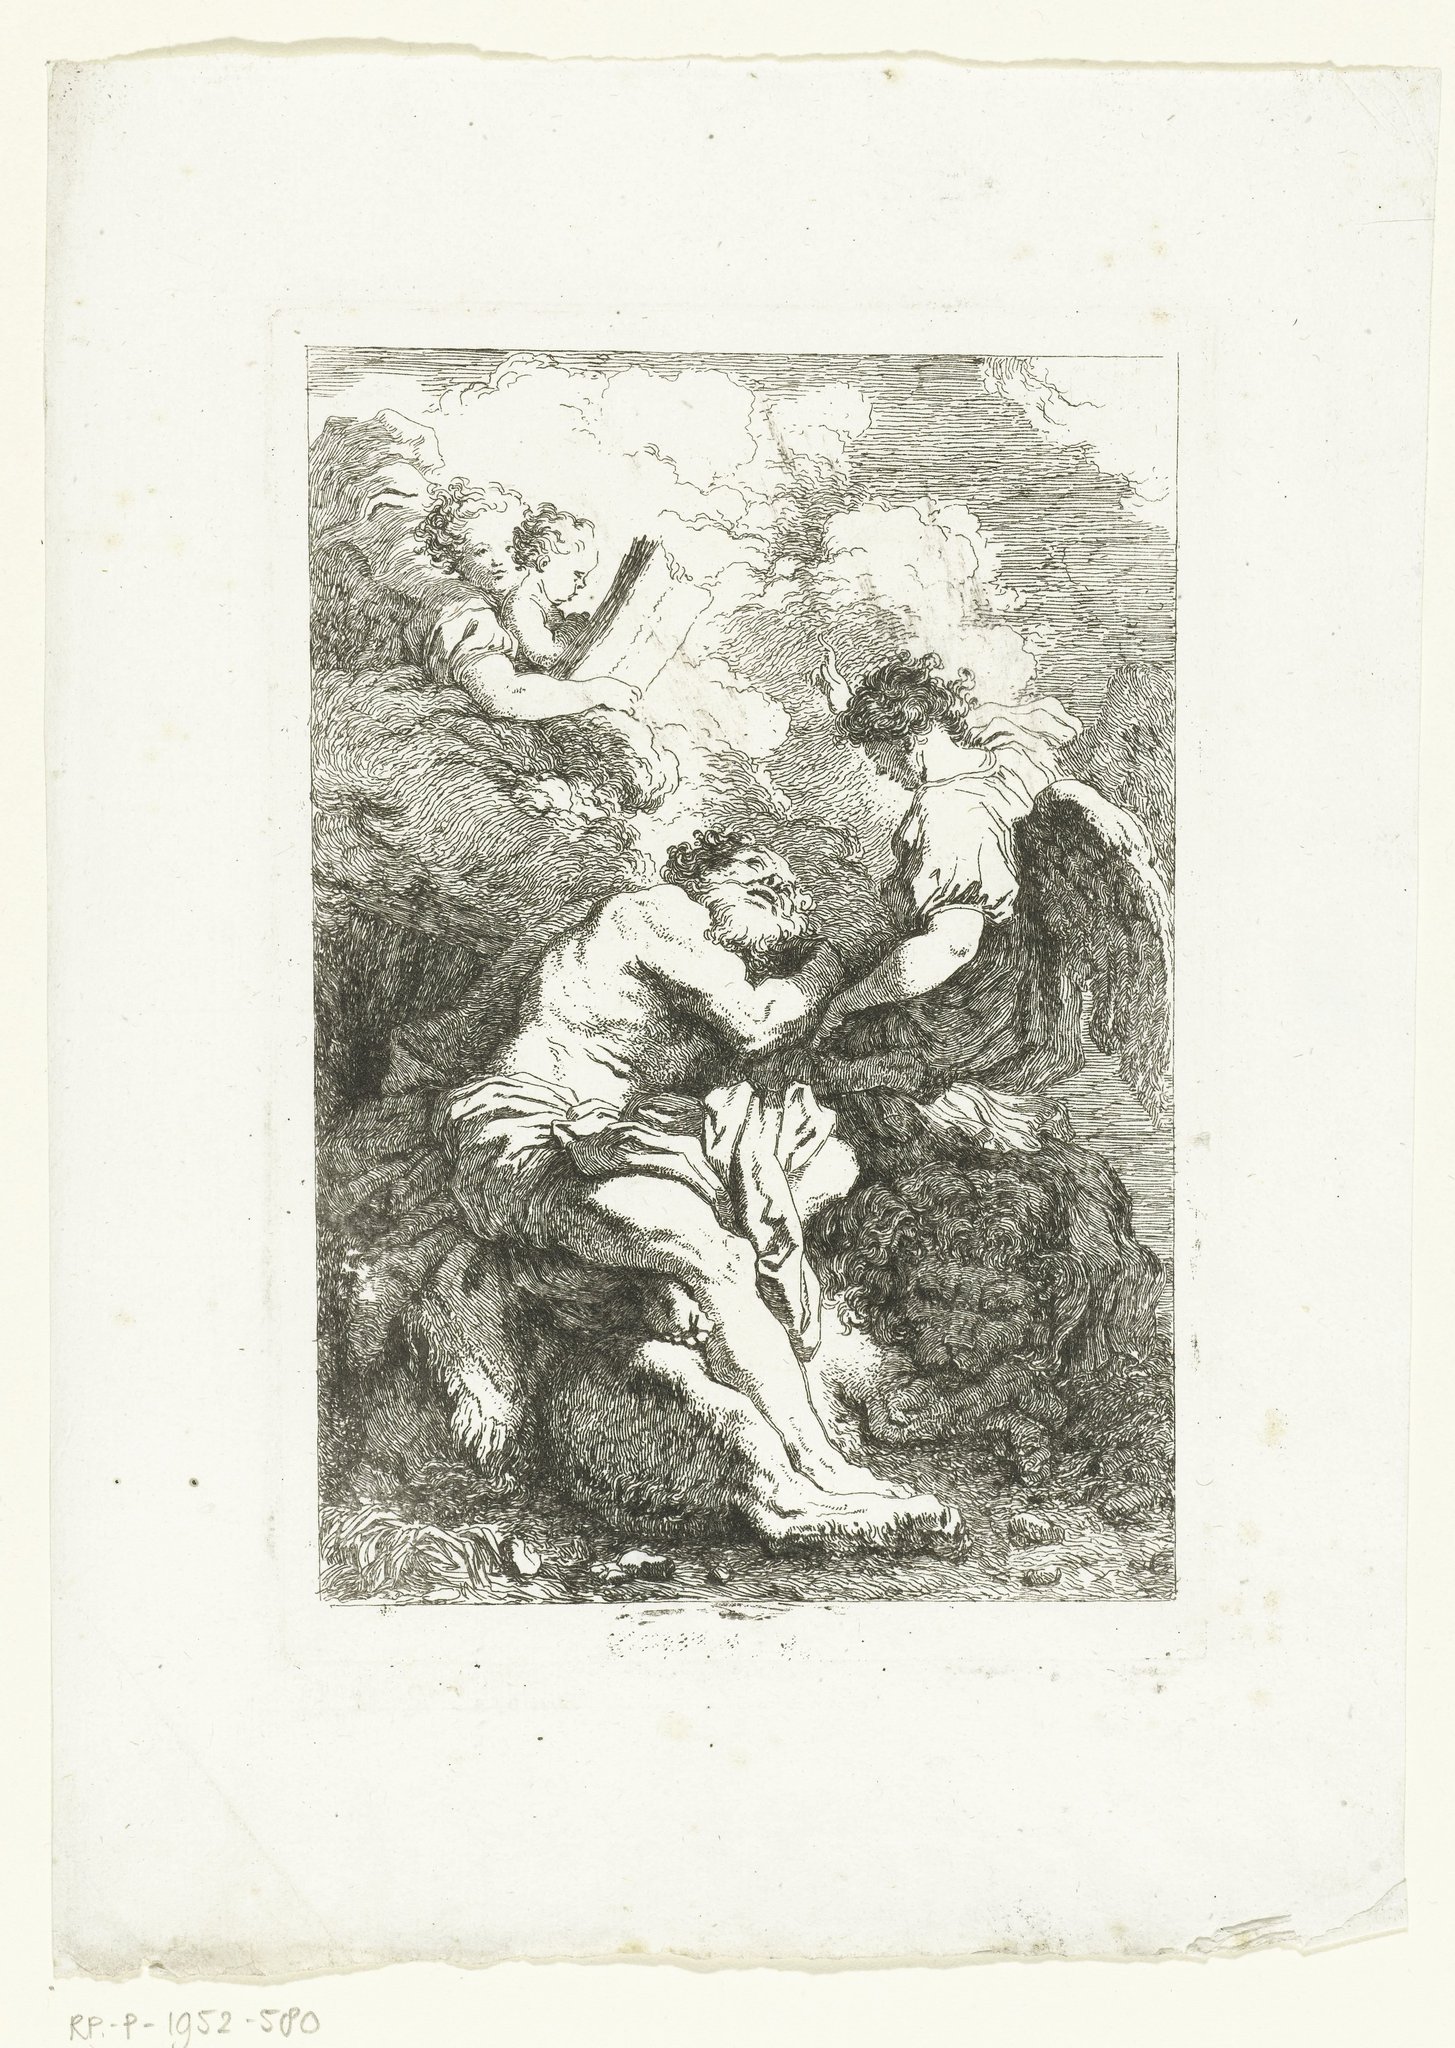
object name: print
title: Heilige Hieronymus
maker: jean honoré fragonard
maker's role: draughtsman, painter, print maker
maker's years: 1732-1806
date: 1763-1764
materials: paper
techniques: etching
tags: the monk and hermit jerome (hieronymus); possible attributes: book, cardinal's hat, crucifix, hour-glass, lion, skull, stone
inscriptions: collector's mark: Lugt 2760, collector's mark: Lugt 2228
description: De heilige Hieronymus liggend, de leeuw bij zijn voeten. Een engel naast hem wijst omhoog. In de wolken twee kinderen met een geschrift in handen.